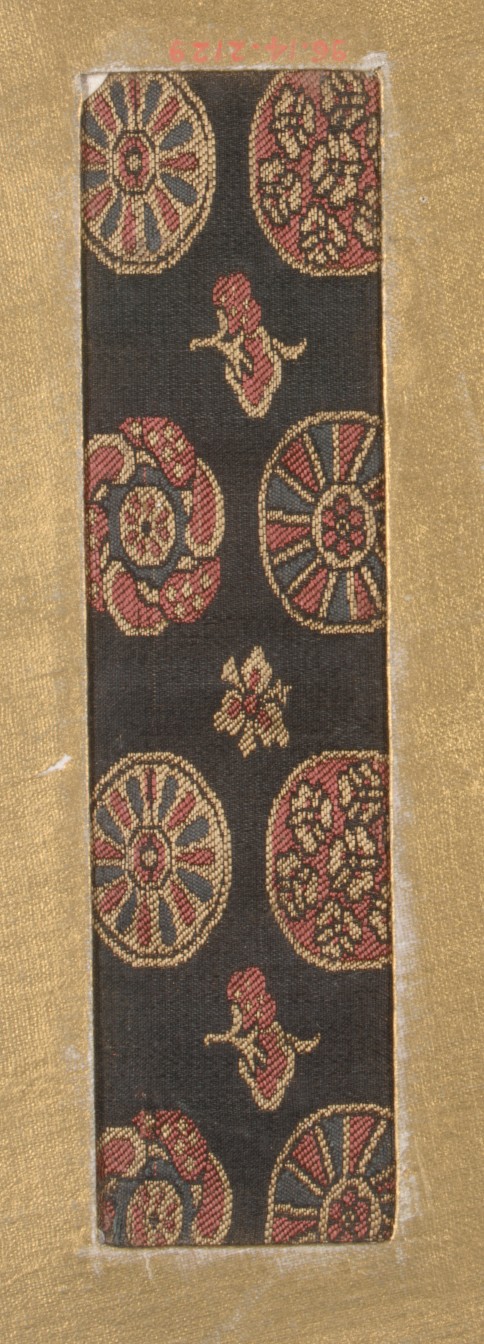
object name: piece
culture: japanese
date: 1701-1900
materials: silk